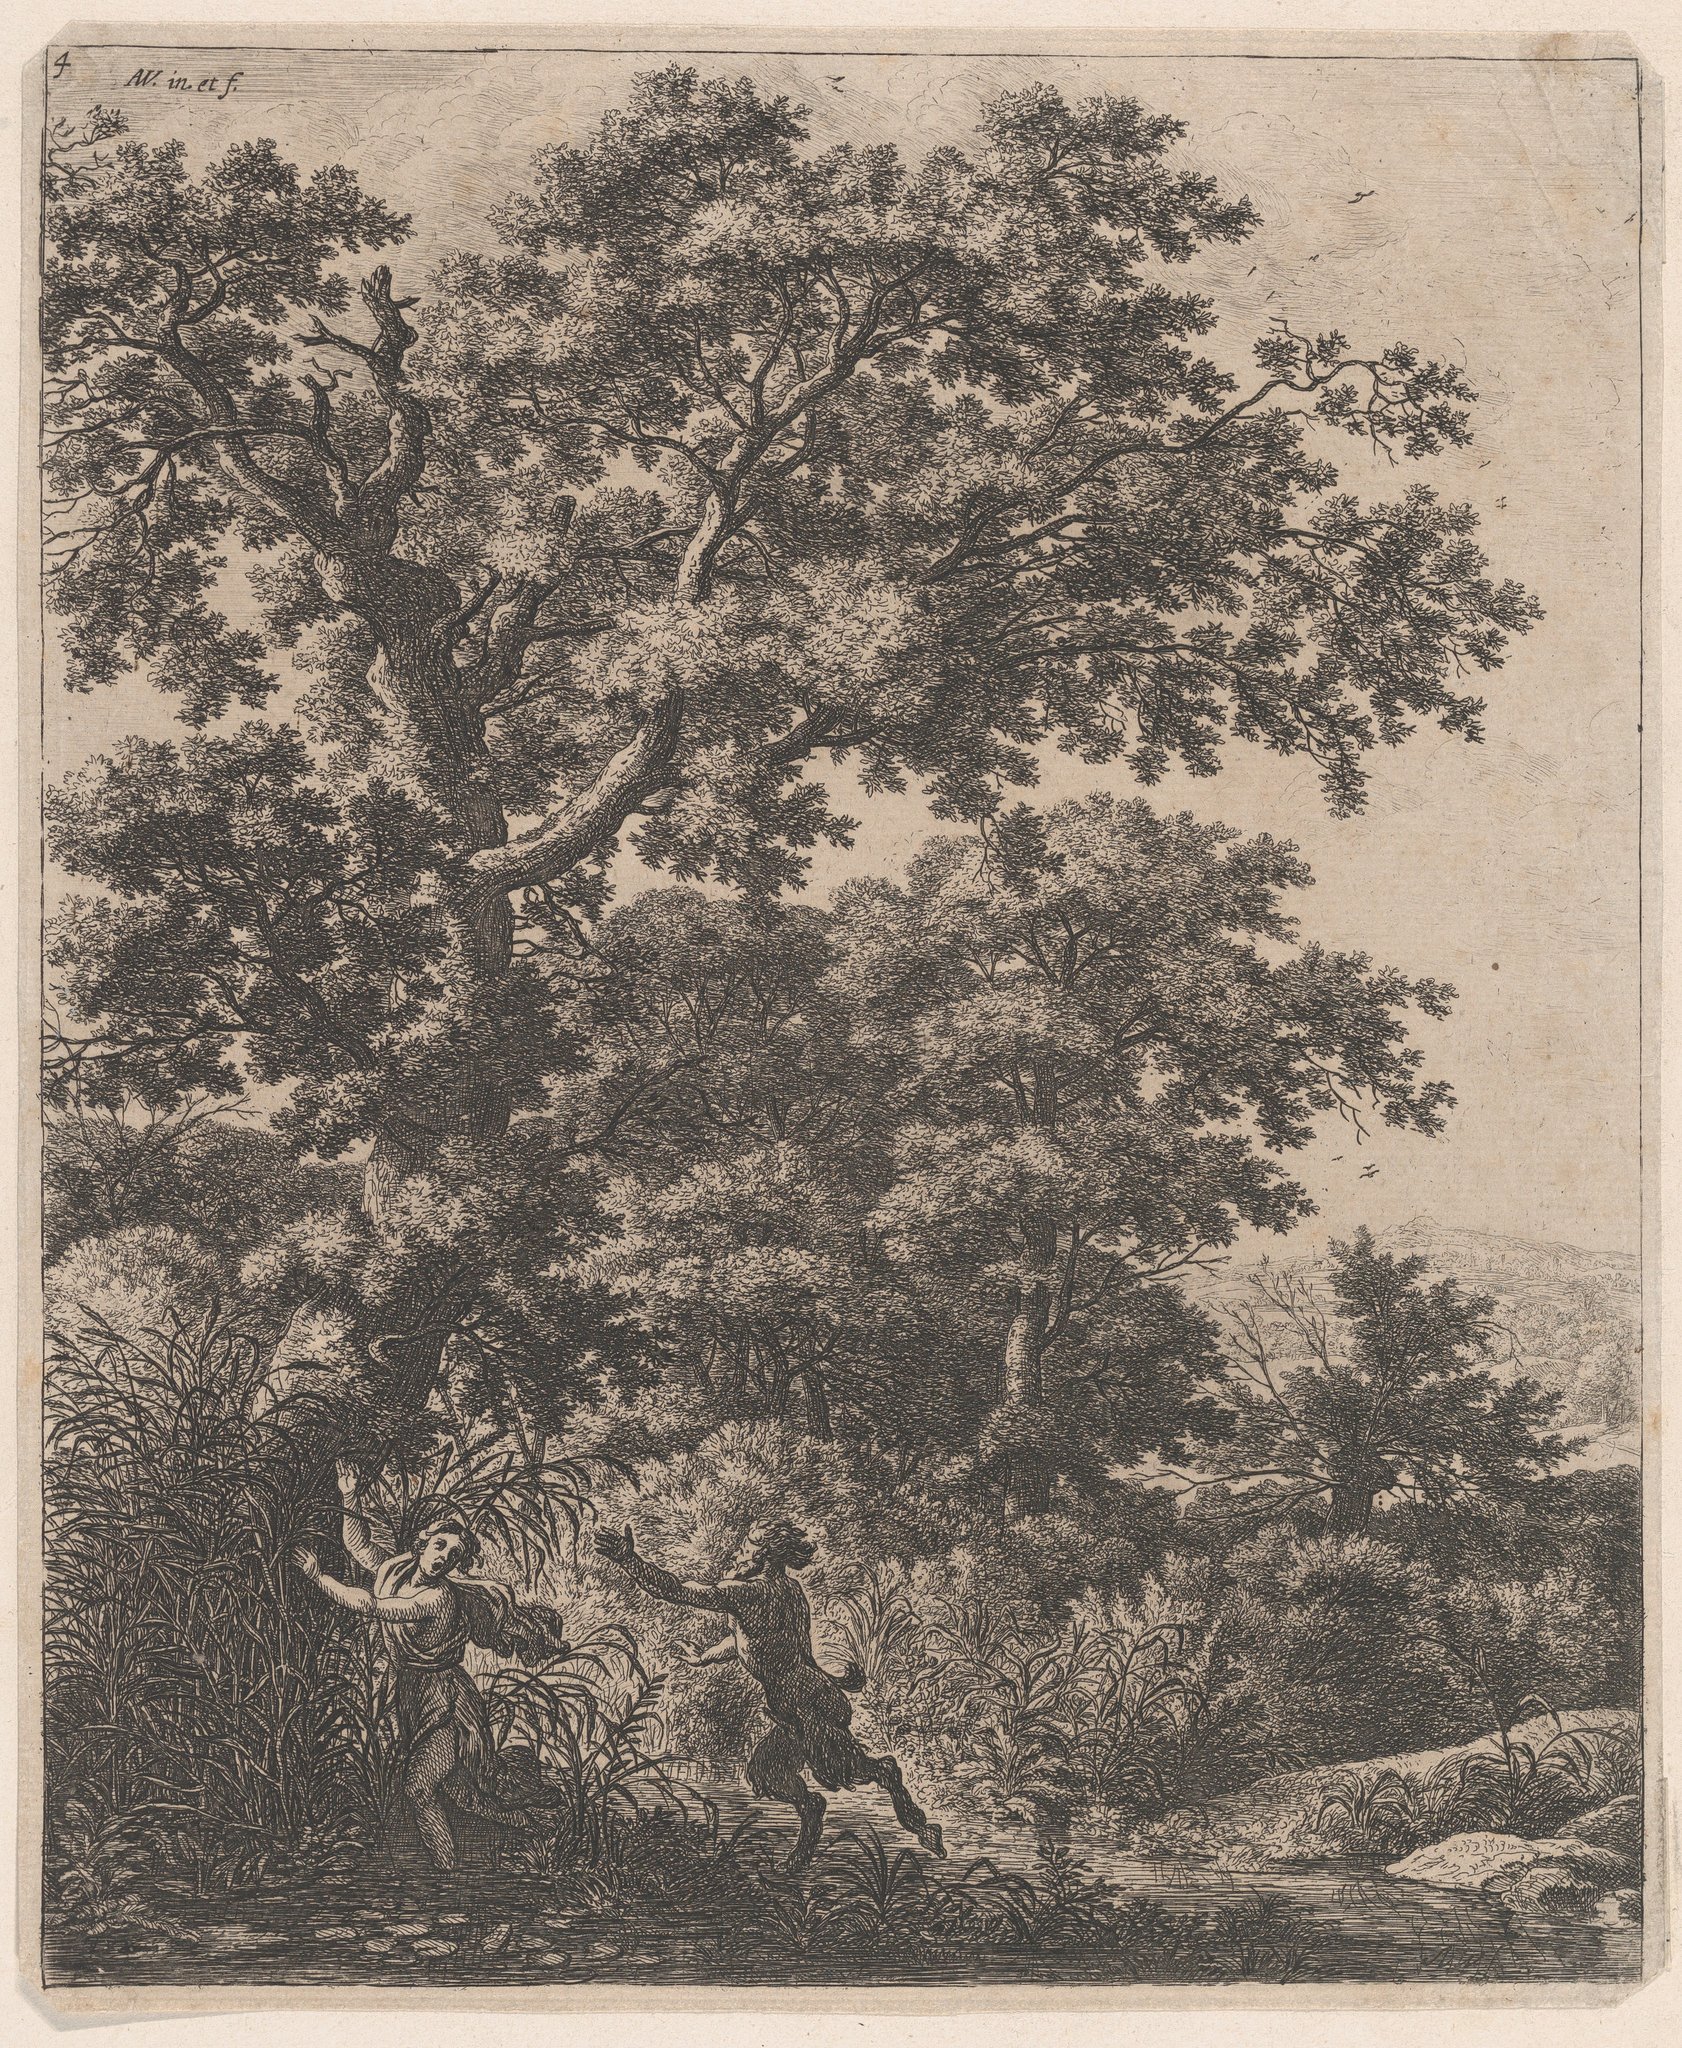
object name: print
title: Pan and Syrinx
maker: anthonie waterloo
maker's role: artist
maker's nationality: dutch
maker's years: 1609-1690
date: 1601-1700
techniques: etching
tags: nymphs,satyrs